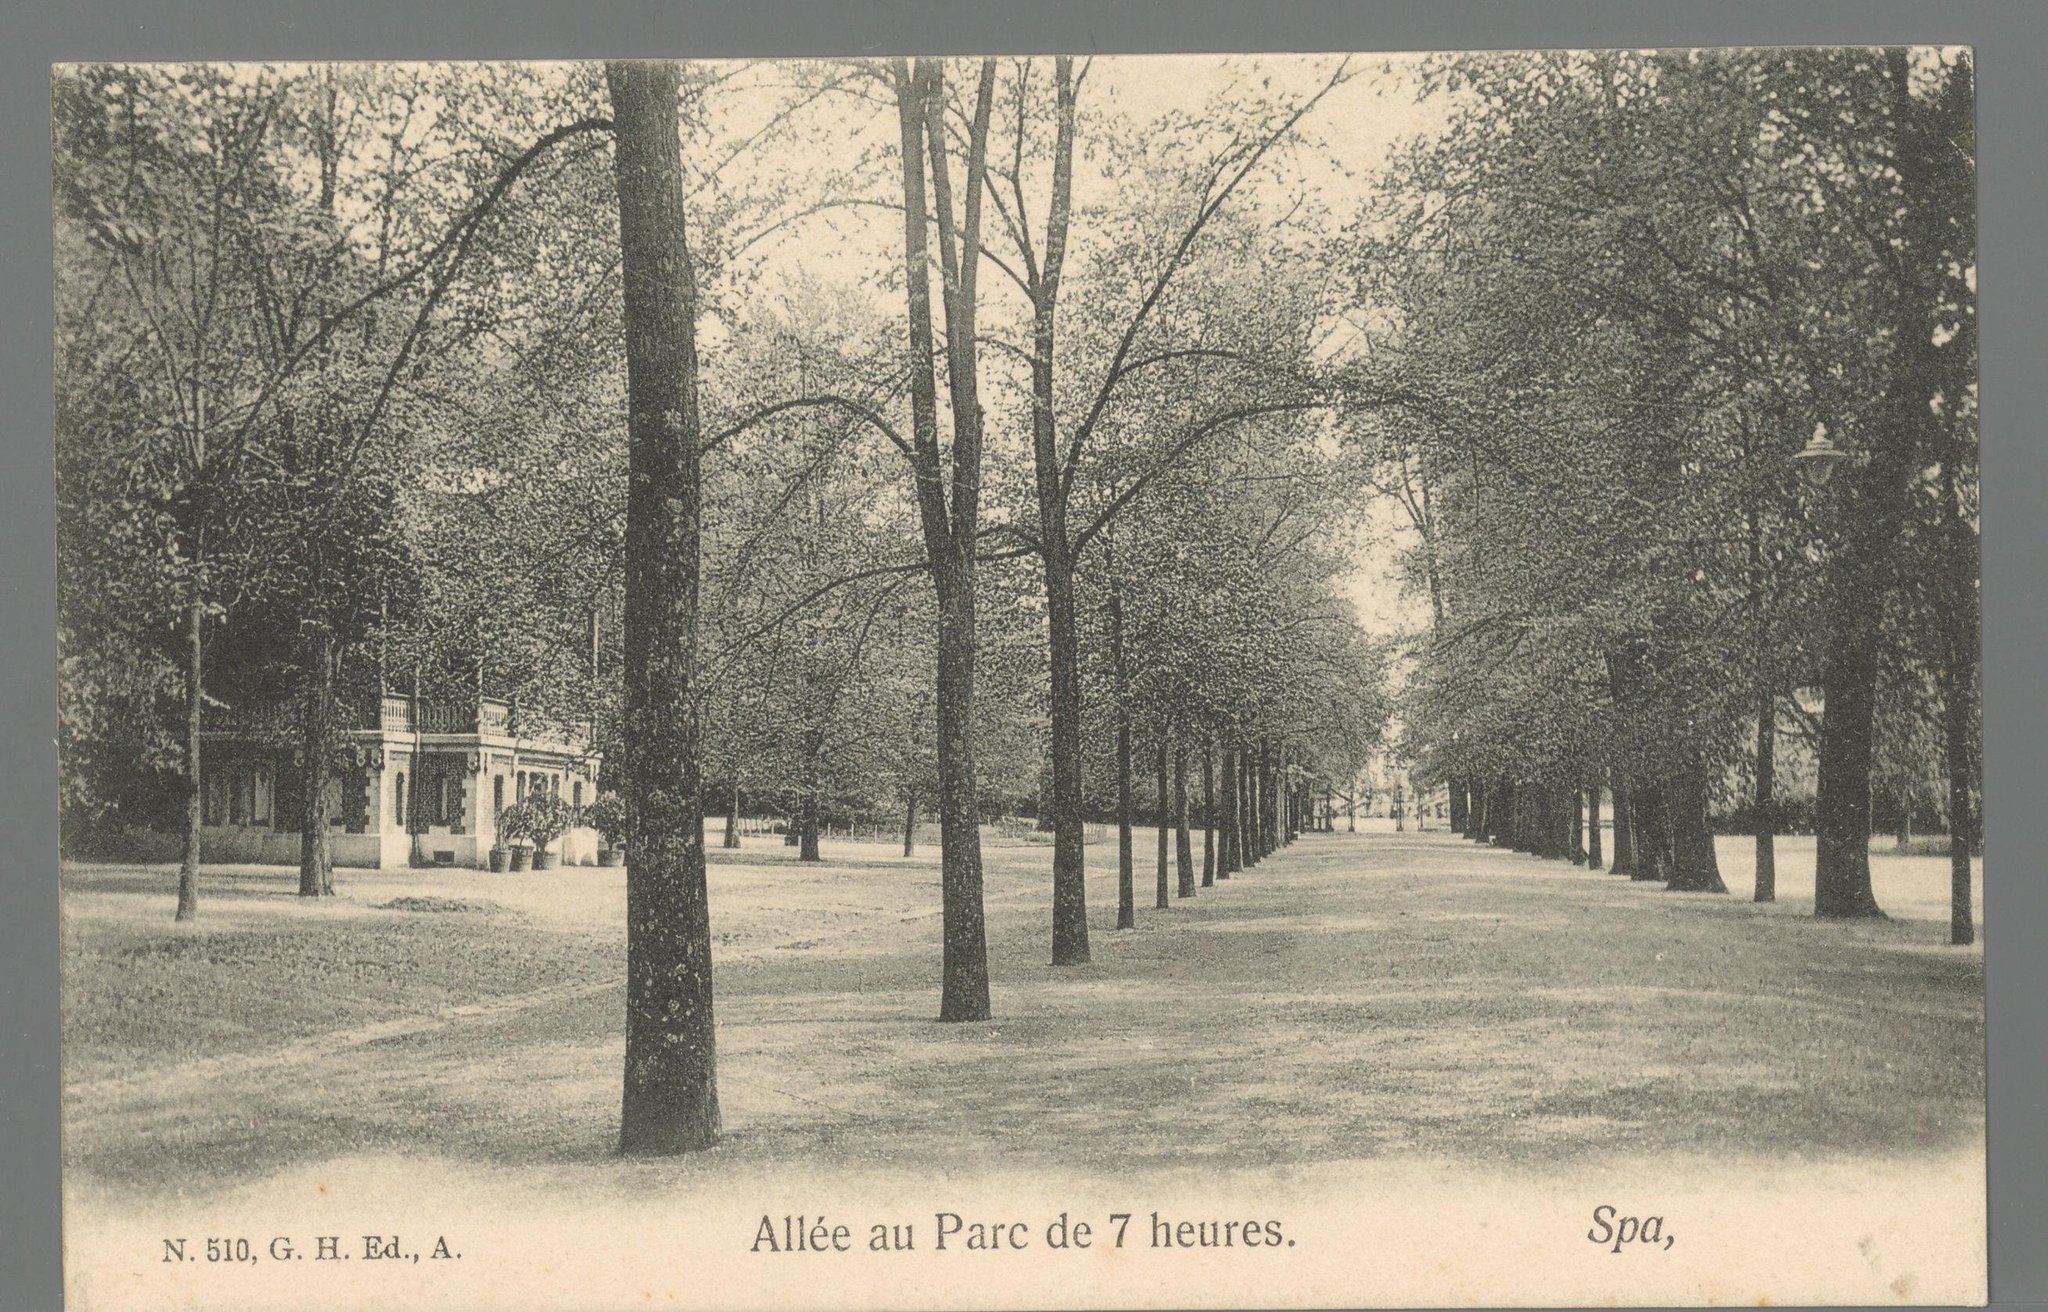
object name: photomechanical print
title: Allée au Parc de 7 heures. Spa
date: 1892-1906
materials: cardboard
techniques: photograph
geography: spa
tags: public gardens, park